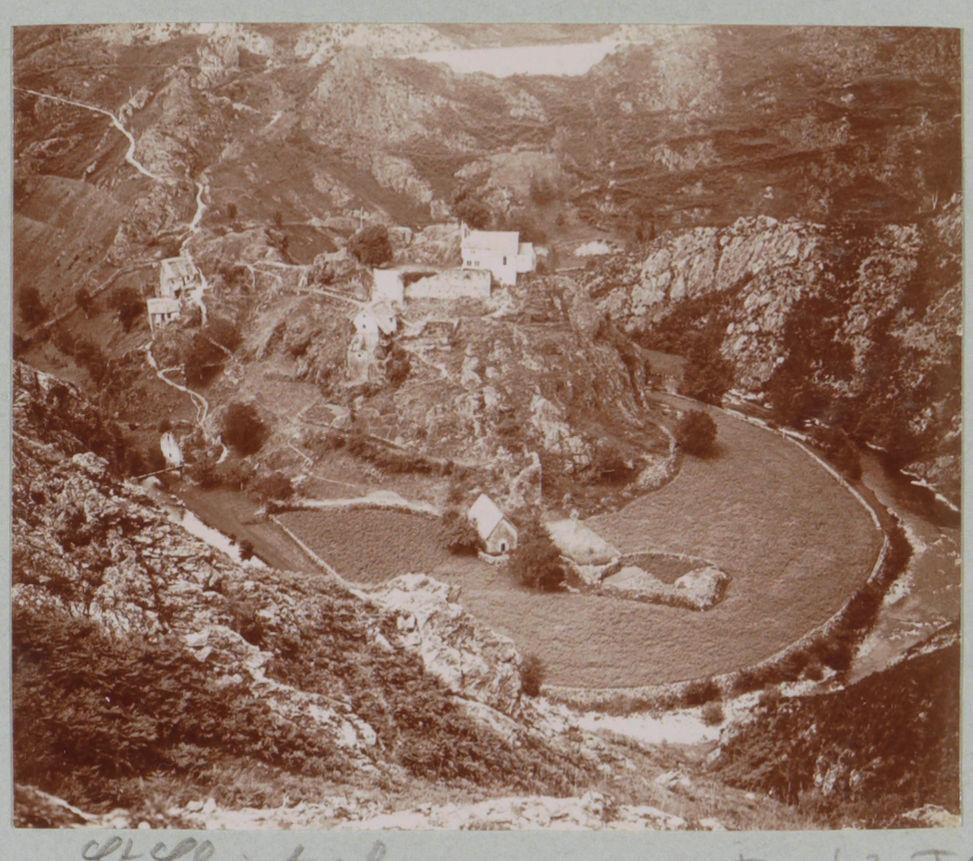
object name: photograph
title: Gezicht op Saint-Christophe in Frankrijk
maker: delizy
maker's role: manufacturer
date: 1903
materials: paper, photographic support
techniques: gelatin silver print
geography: france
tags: prospect of village, silhouette of village, france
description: Onderdeel van Fotoalbum van een Franse amateurfotograaf met opnames van uitstapjes in Frankrijk, Spanje, België, Luxemburg en Nederland, de eerste automobielen en autoraces.